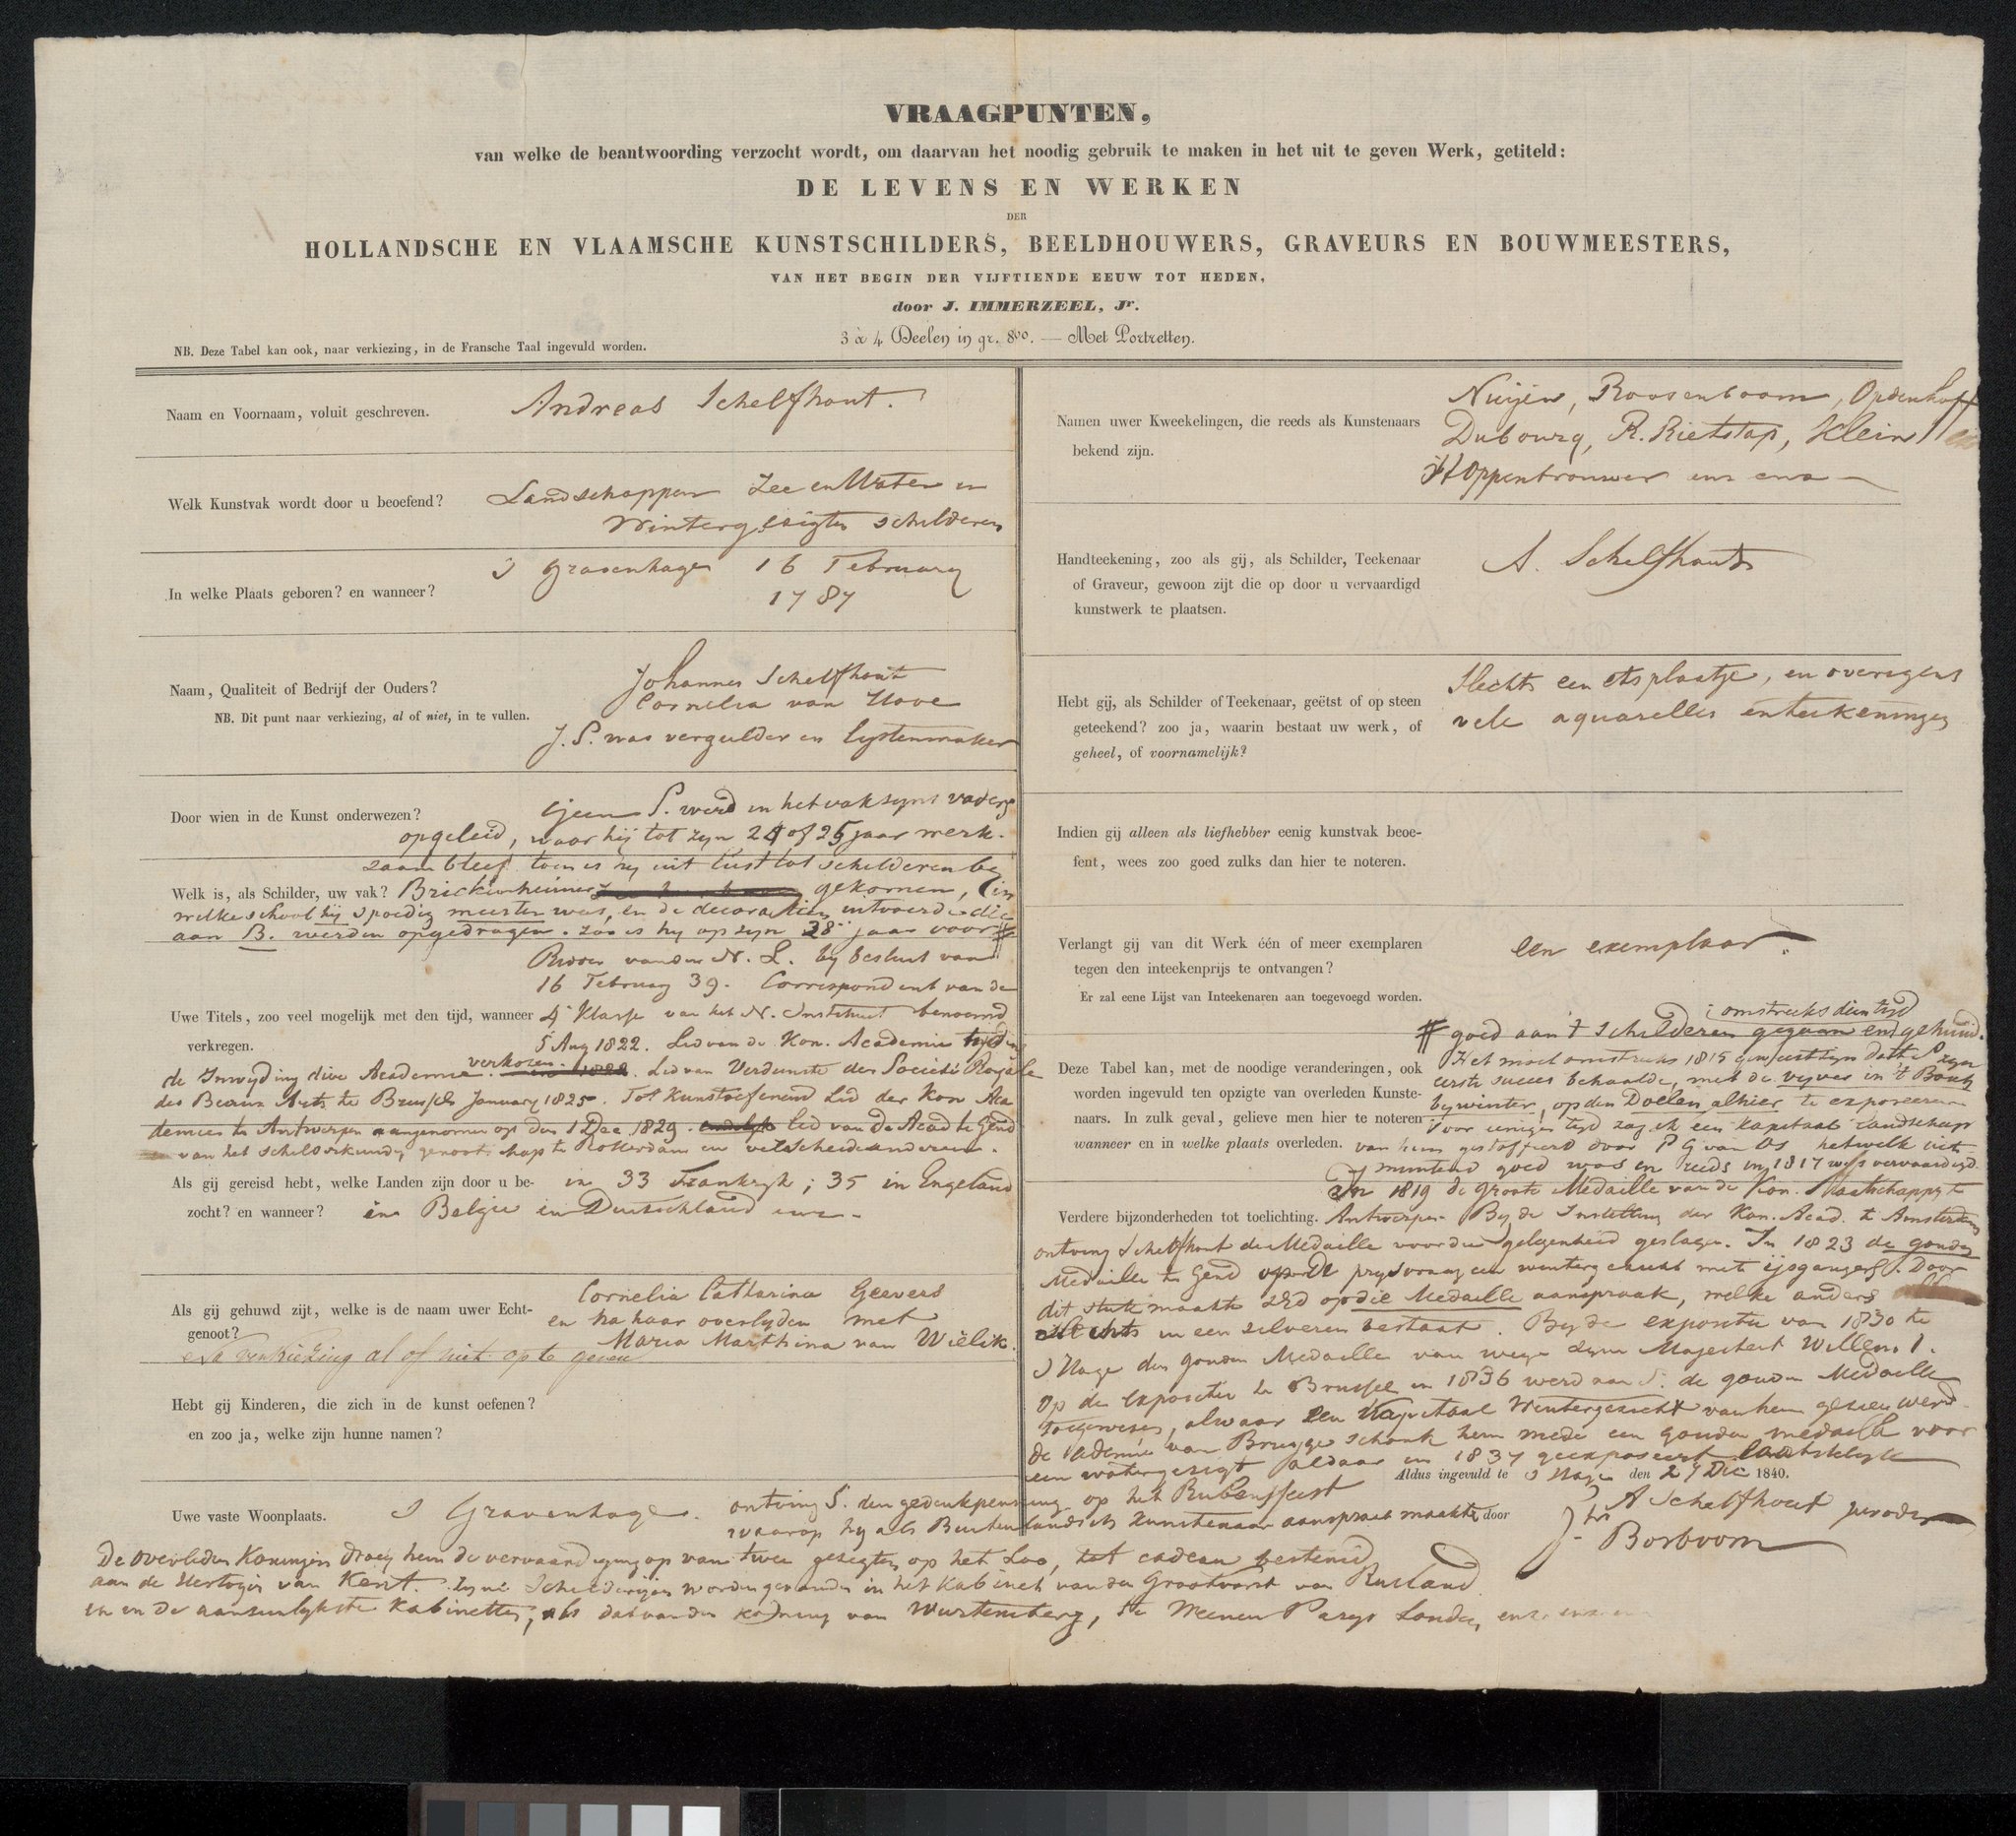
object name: questionnaire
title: Enquêteformulier betreffende Andreas Schelfhout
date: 1840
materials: ink, paper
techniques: pen, printing, writing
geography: the hague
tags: the hague, painter, print maker, draughtsman, andreas schelfhout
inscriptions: inscription: ‘Vraagpunten,/ van welke de beantwoording verzocht wordt, om daarvan het noodig gebruik te maken in het uit te geven Werk, getiteld: De levens en werken/ der Hollandsche en Vlaamsche kunstschilders, beeldhouwers,/ graveurs en bouwmeesters, van het begin der vijftiende eeuw tot heden/ door J. Immerzeel, Jr.’, watermark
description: Opgenomen in: Immerzeel, J. Jr., De levens en werken der Hollandsche en Vlaamsche kunstschilders, beeldhouwers, graveurs en bouwmeesters, van het begin der vijftiende eeuw tot heden, Amsterdam: J.C. van Kesteren, 1842-1843.